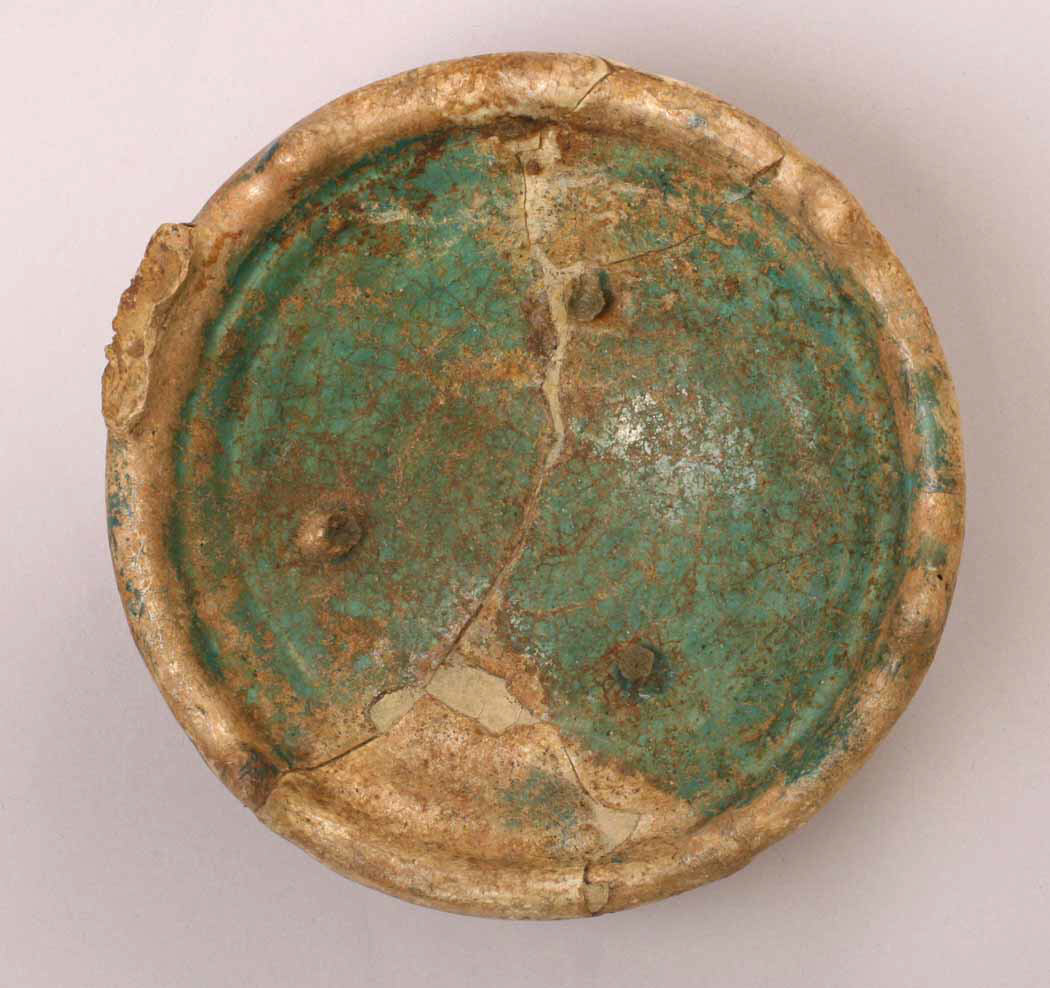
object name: bowl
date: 901-1000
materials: earthenware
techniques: glazing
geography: iraq